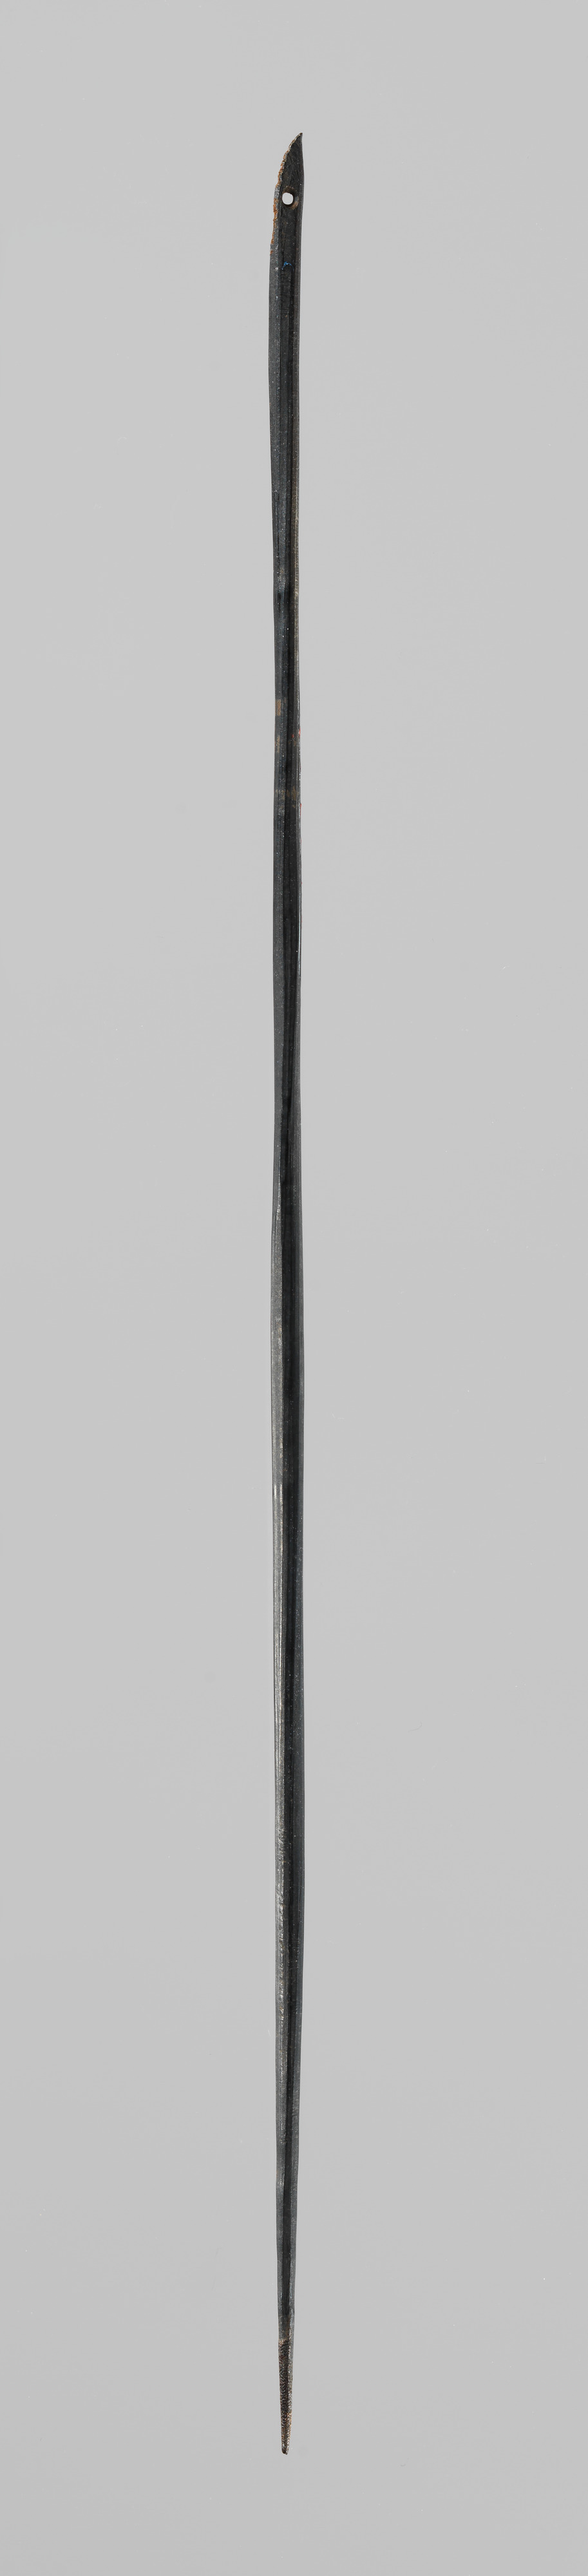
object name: needle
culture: peruvian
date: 901-1600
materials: wood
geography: peru